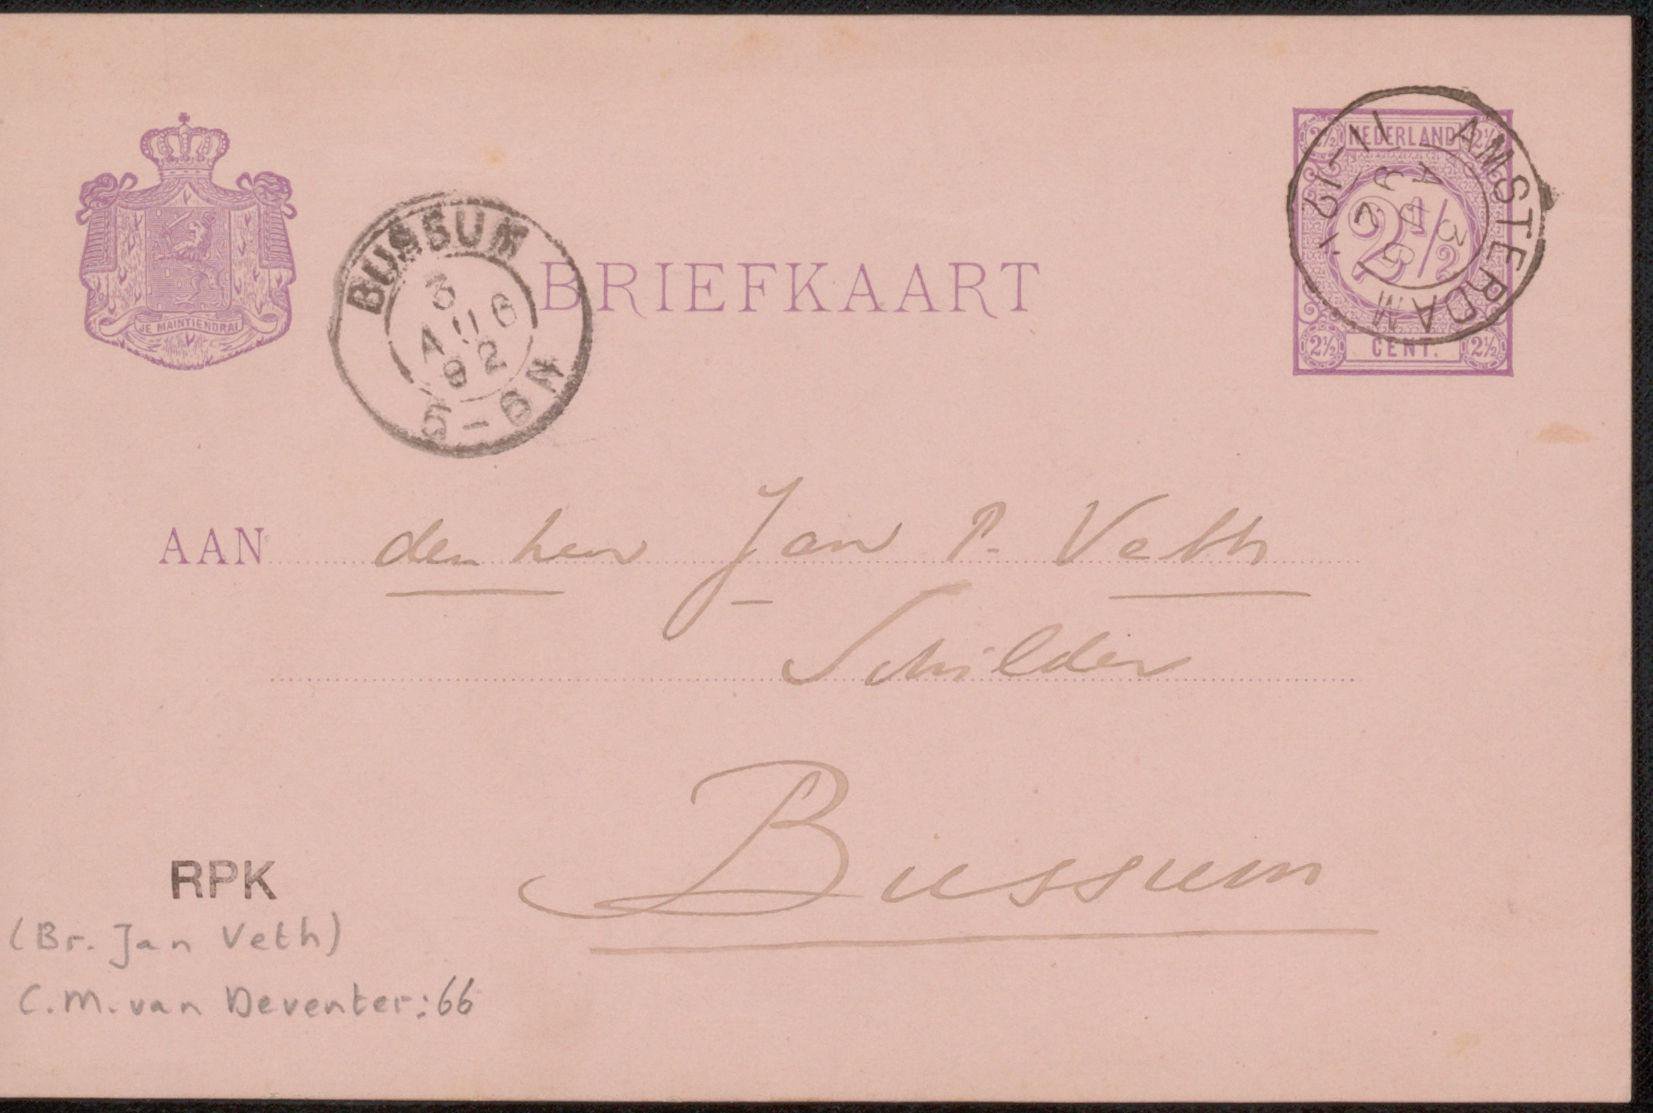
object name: postcard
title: Briefkaart aan Jan Veth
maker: chap van deventer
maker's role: kunstcriticus, scheikundige, schrijver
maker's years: 1860-1931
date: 1892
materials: cardboard, ink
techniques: pen, writing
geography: amsterdam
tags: painter, draughtsman, designer, jan veth, middelburg, politician, pieter lodewijk tak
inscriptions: collector's mark: ‘RPK’